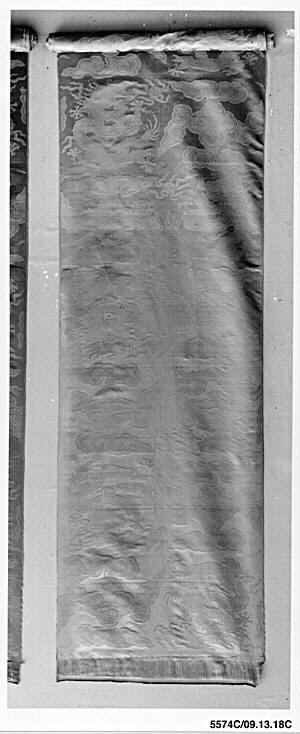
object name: do not use this record duplicate of 09. 13. 18a d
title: Piece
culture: chinese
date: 1801-1900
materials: silk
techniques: weave